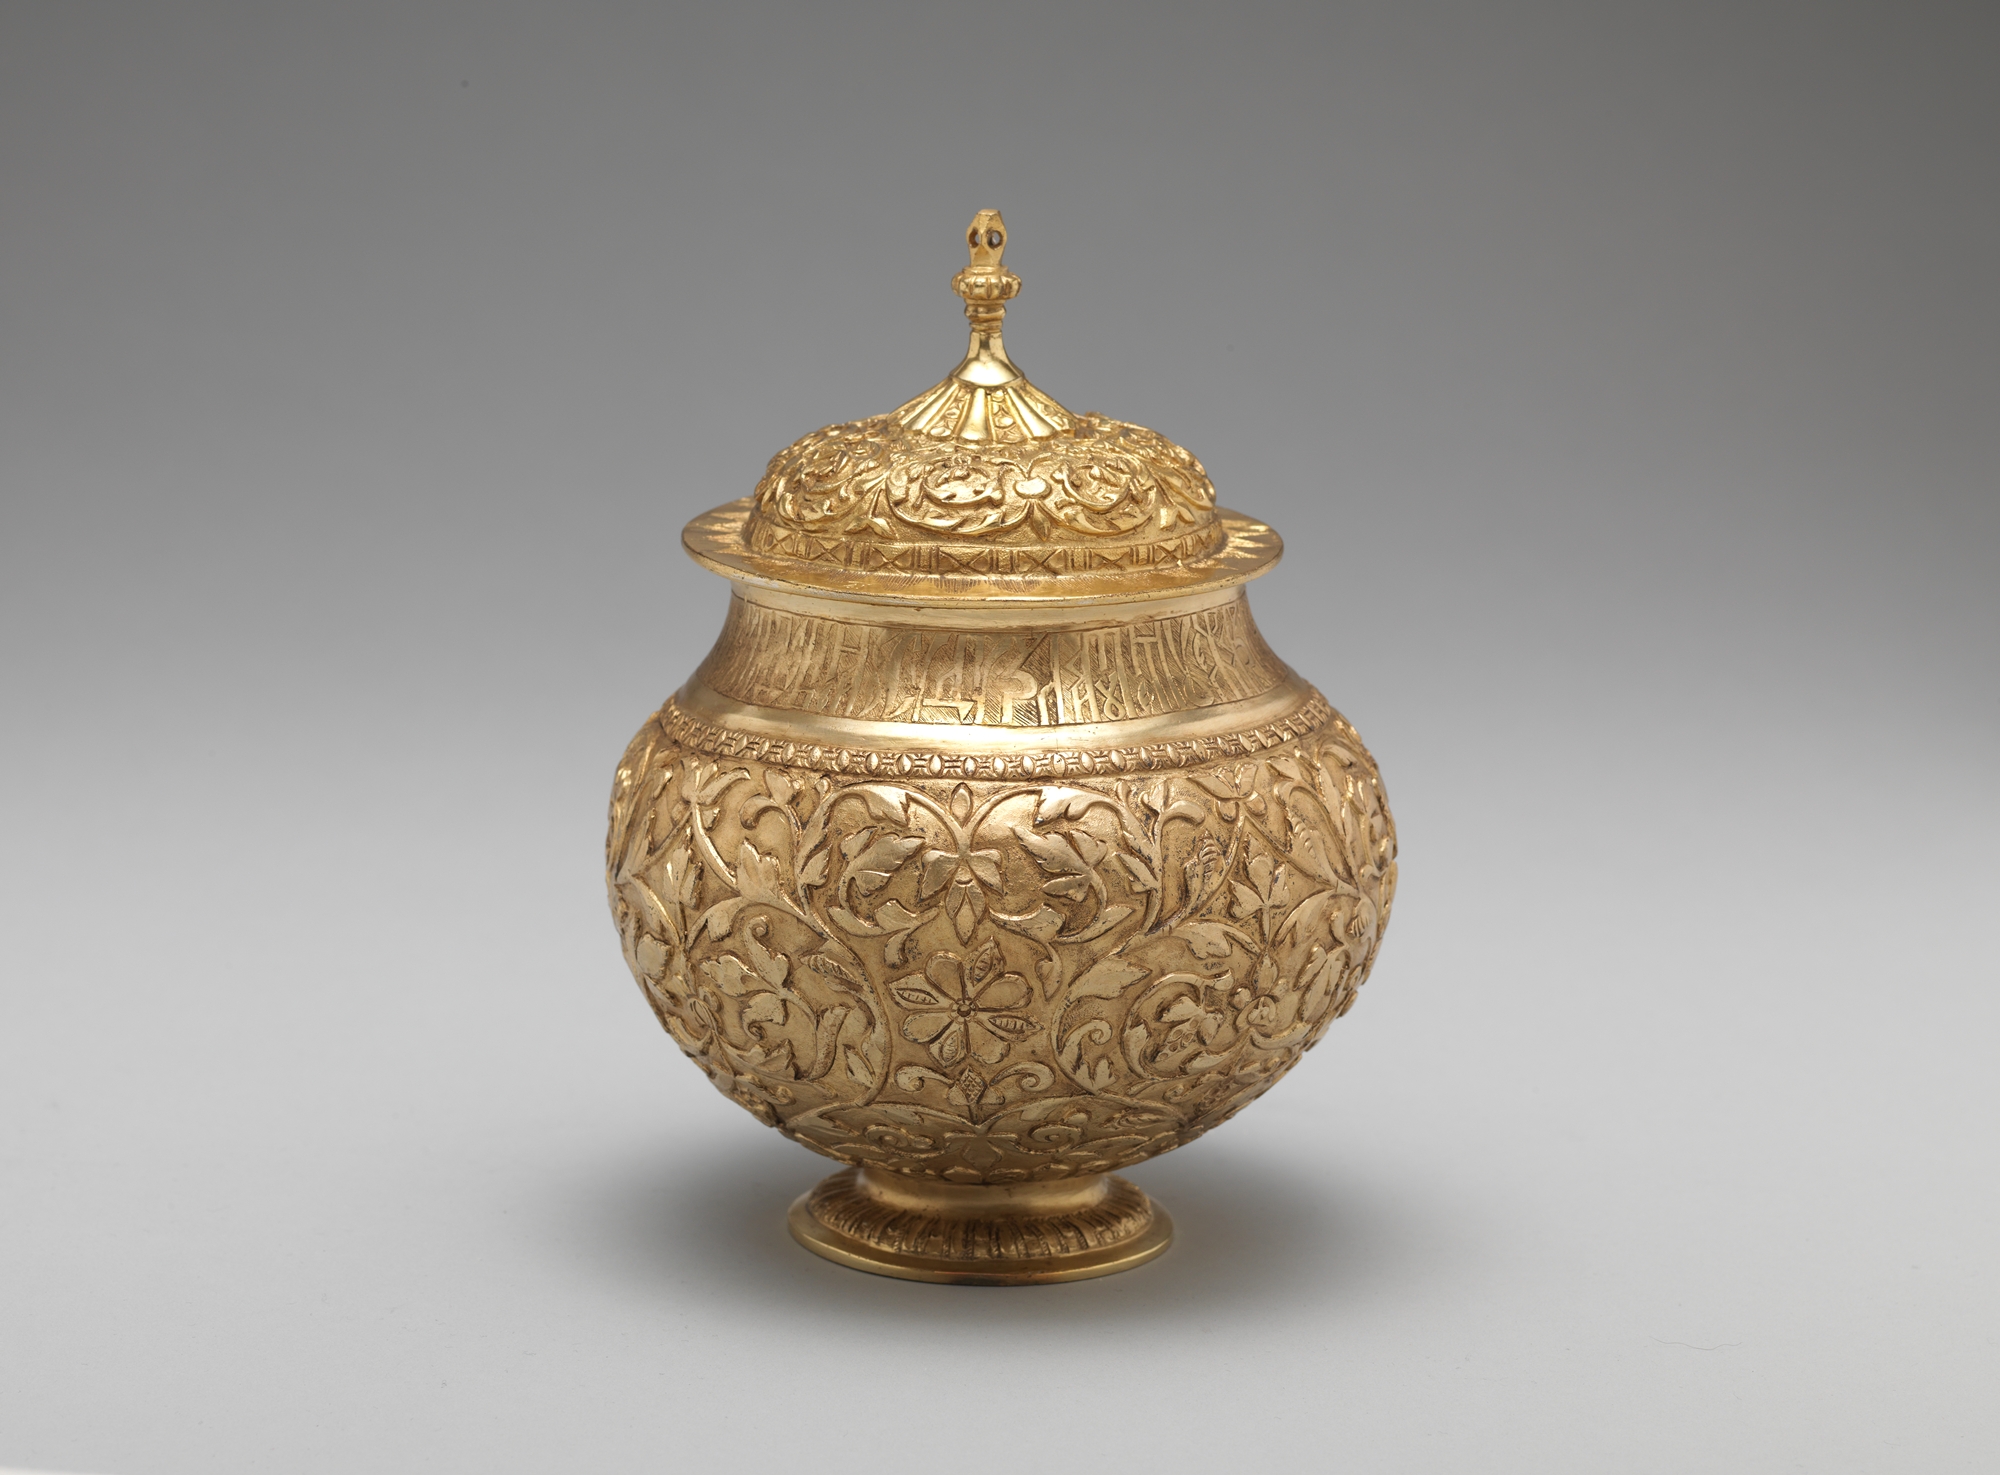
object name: bratina with cover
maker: elkington & co.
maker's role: manufacturer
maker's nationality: british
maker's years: 1829-1963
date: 1801-1900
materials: silver gilt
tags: flowers,leaves